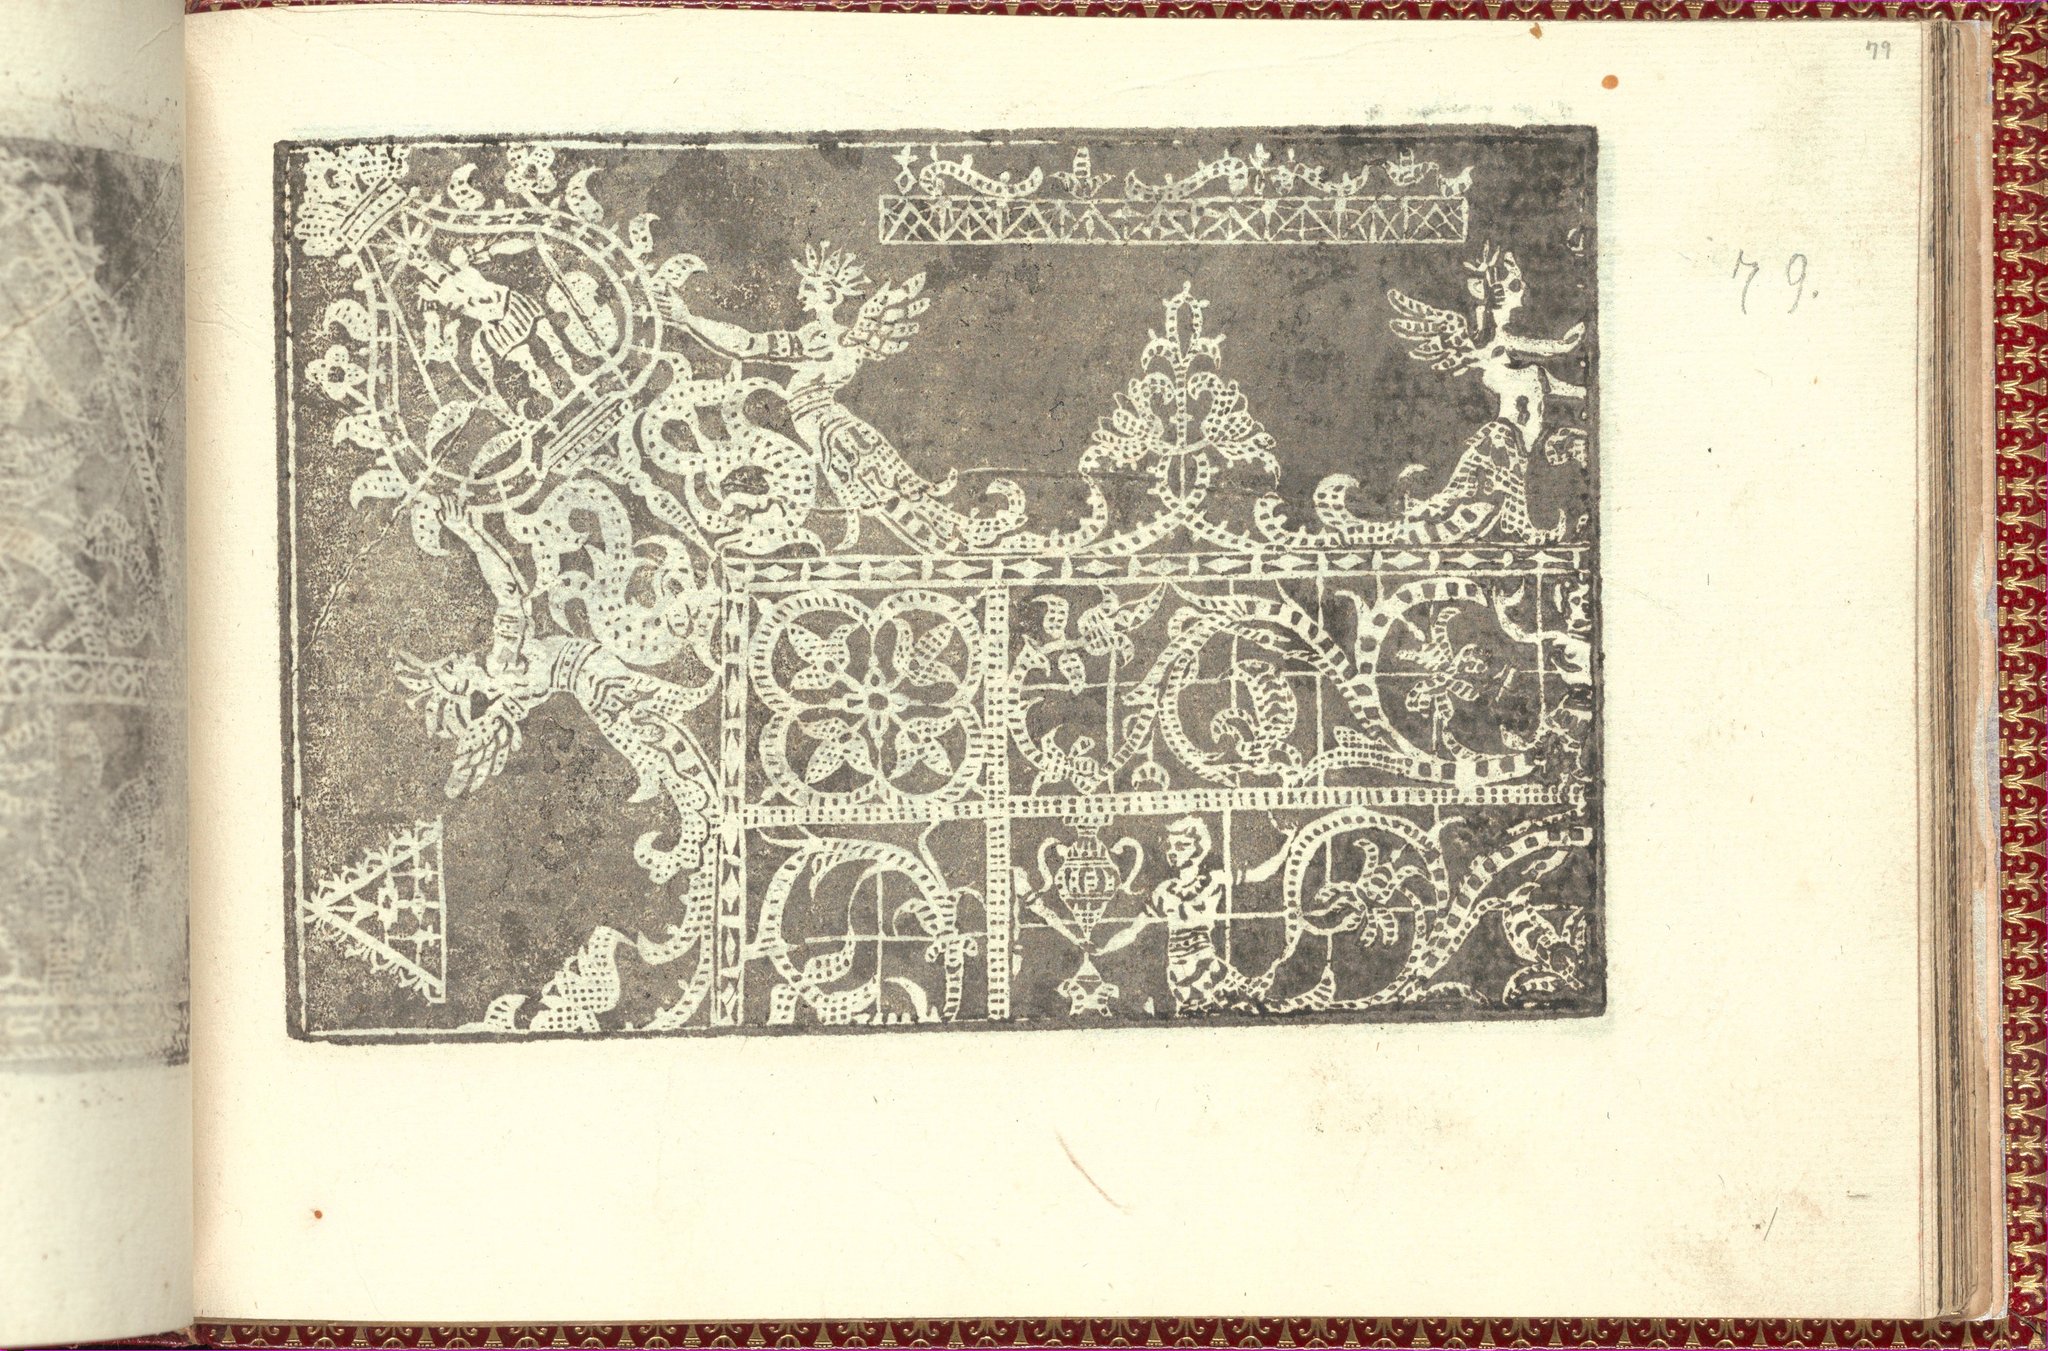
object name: book print ornament architecture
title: Corona delle Nobili et Virtuose Donne: Libro I-IV, page 79 (recto)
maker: cesare vecellio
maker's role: publisher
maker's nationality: italian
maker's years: 1521-1601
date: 1601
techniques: woodcut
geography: italy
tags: ornament